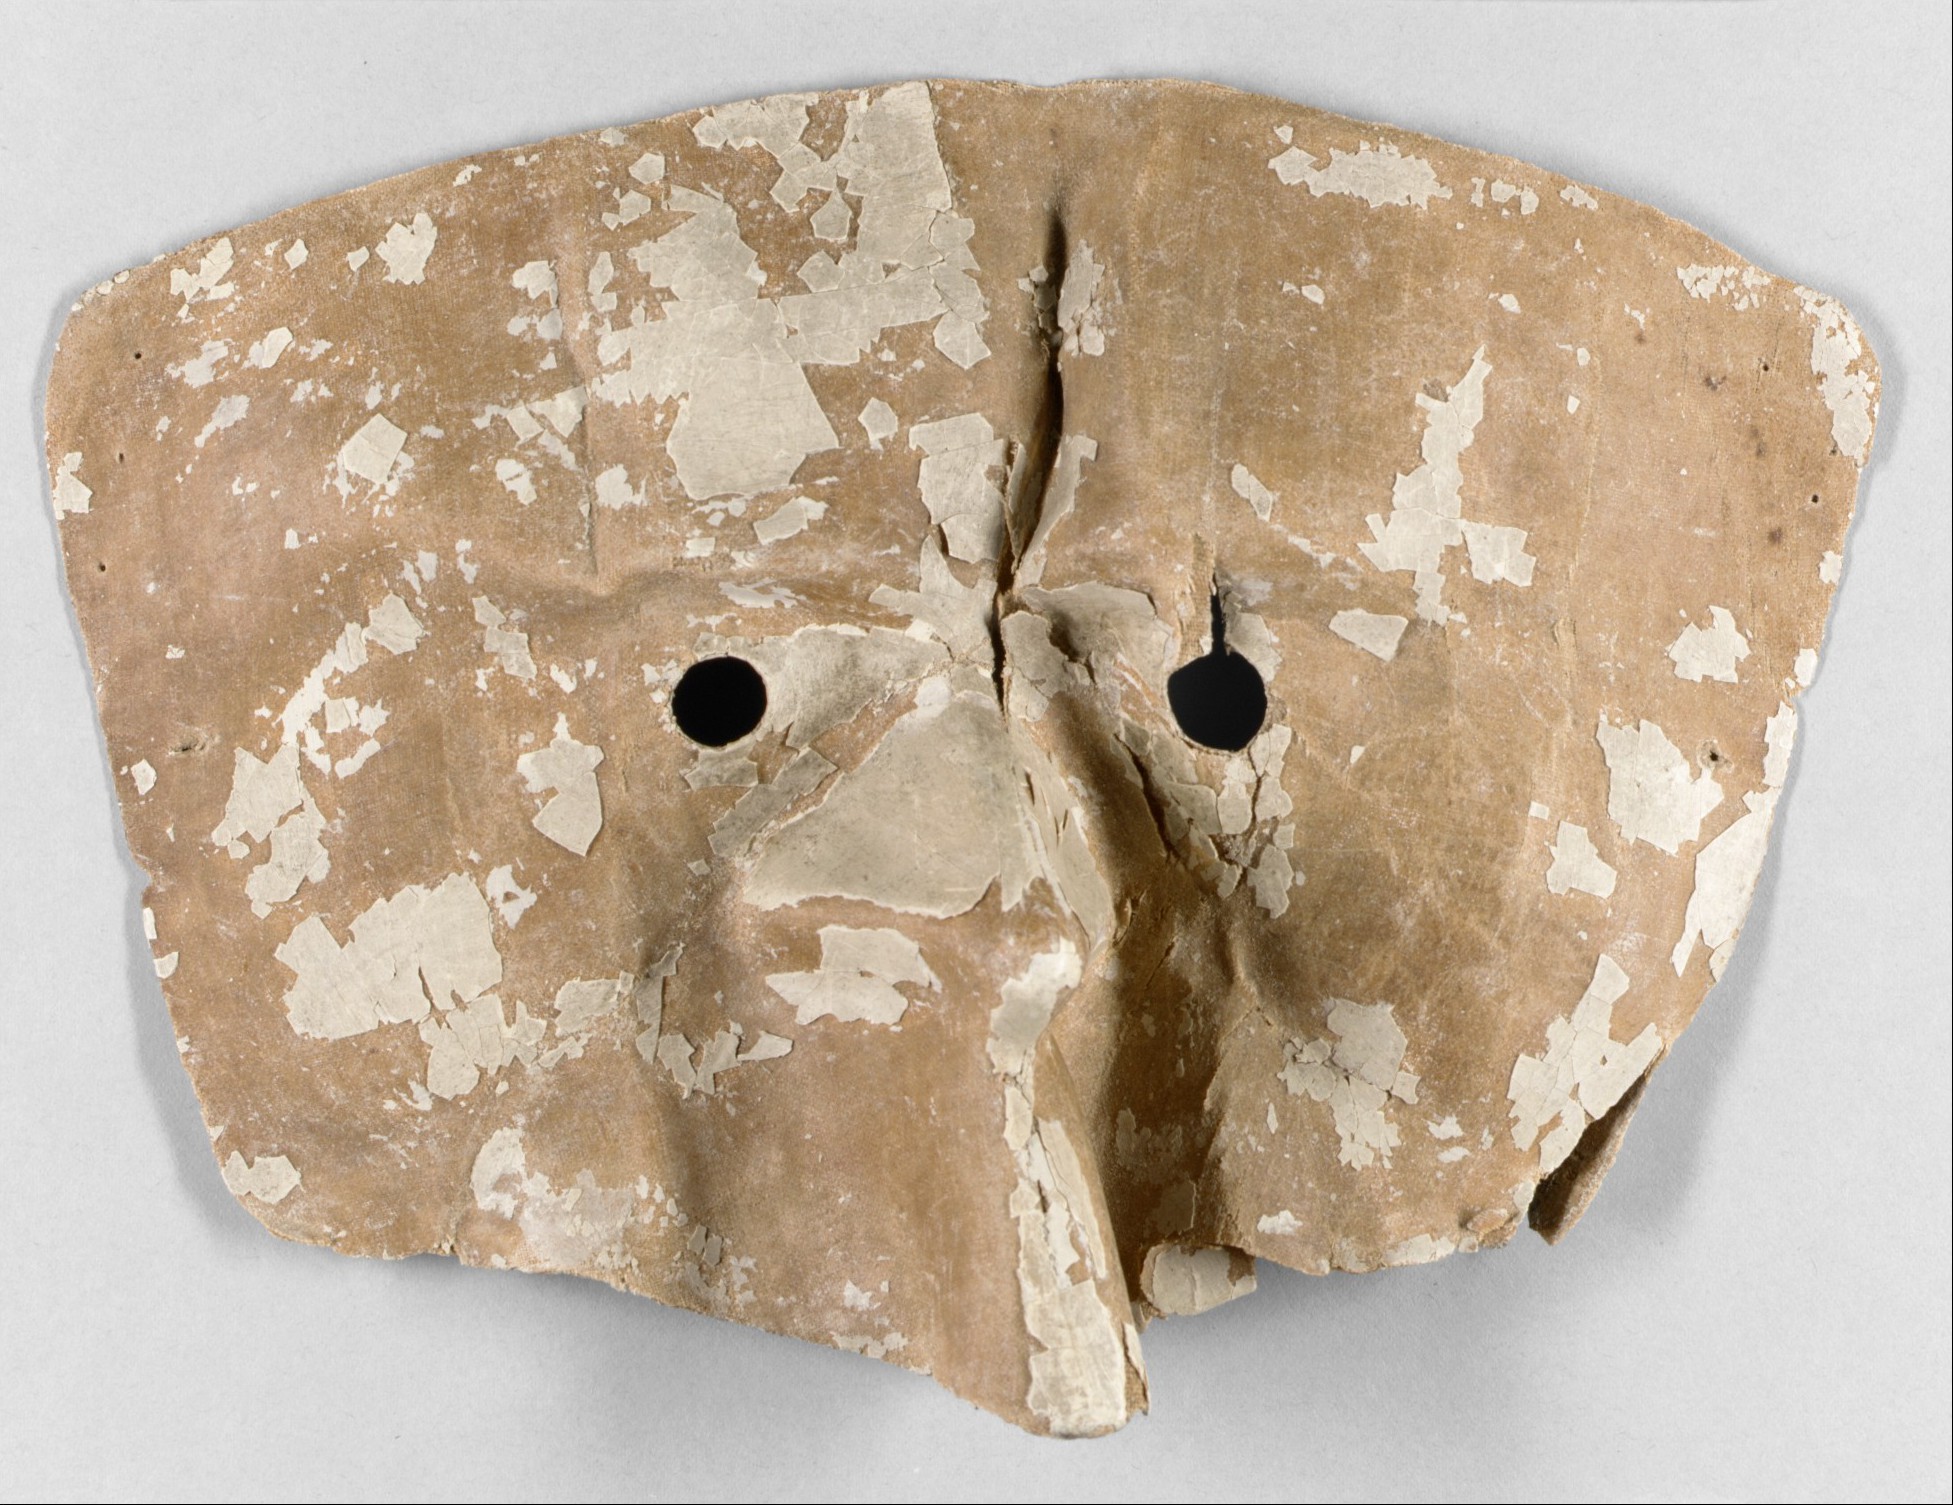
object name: mask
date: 1750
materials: canvas